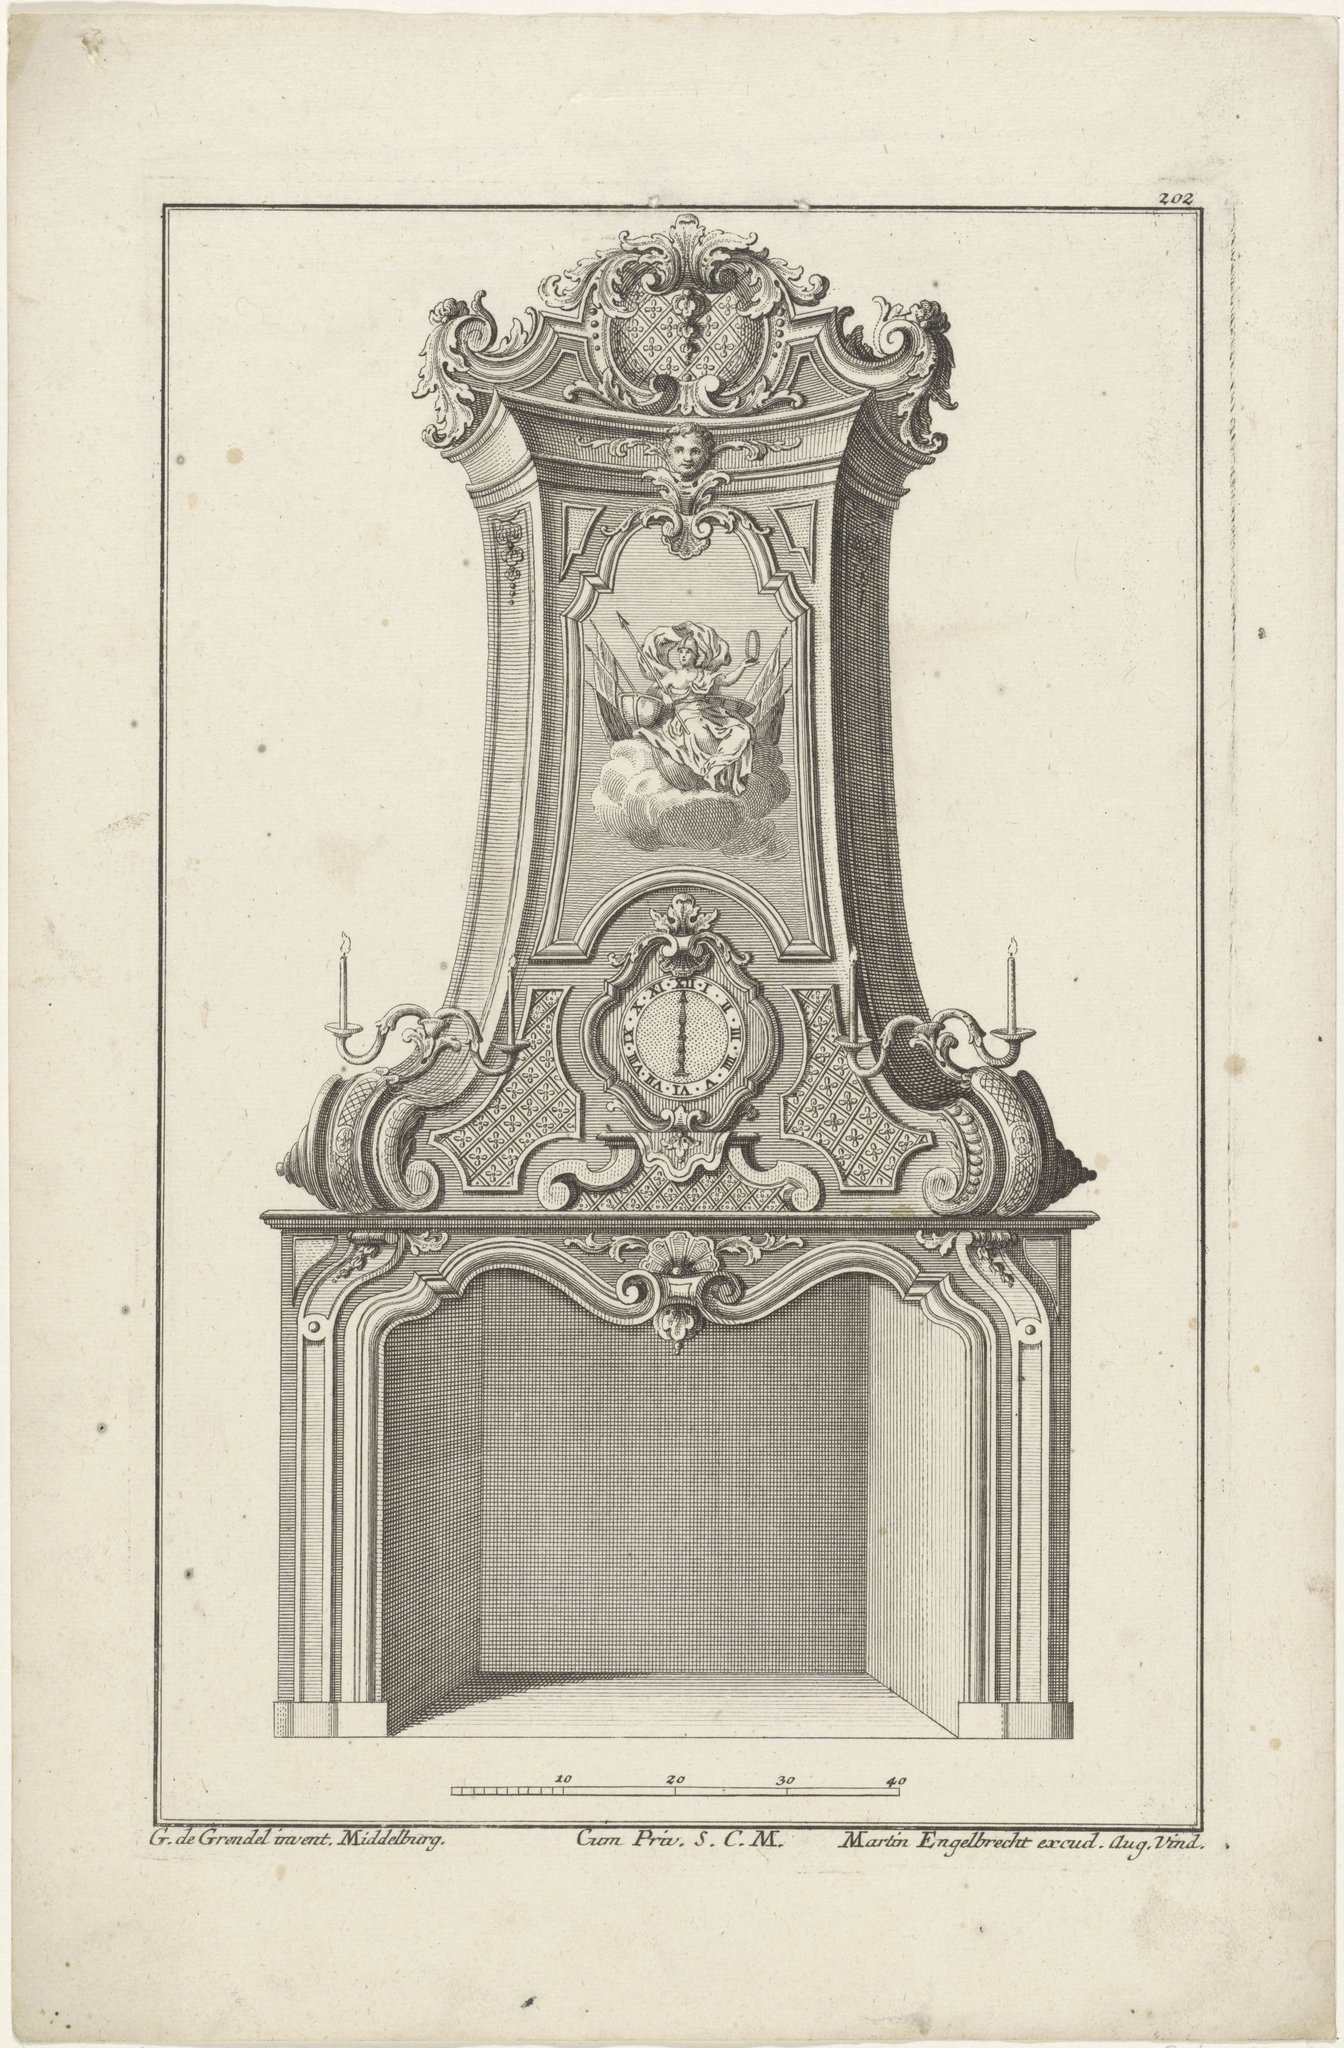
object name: ornament print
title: Neü inventierte Camine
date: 1708-1756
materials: paper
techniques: engraving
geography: middelburg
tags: chimney, ornaments ~ art, (story of) minerva (pallas, athena), clock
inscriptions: collector's mark: Lugt 2228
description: Ontwerp voor een schoorsteen met een voorstelling van Minerva, tronend op een wolk, omringd door vlaggen en met een eeuwigheidssymbool in de hand. Midden op de schoorsteenmantel een klok. Aan weerszijden kaarsen. Midden onder een schaalverdeling. Prentnummer 202.